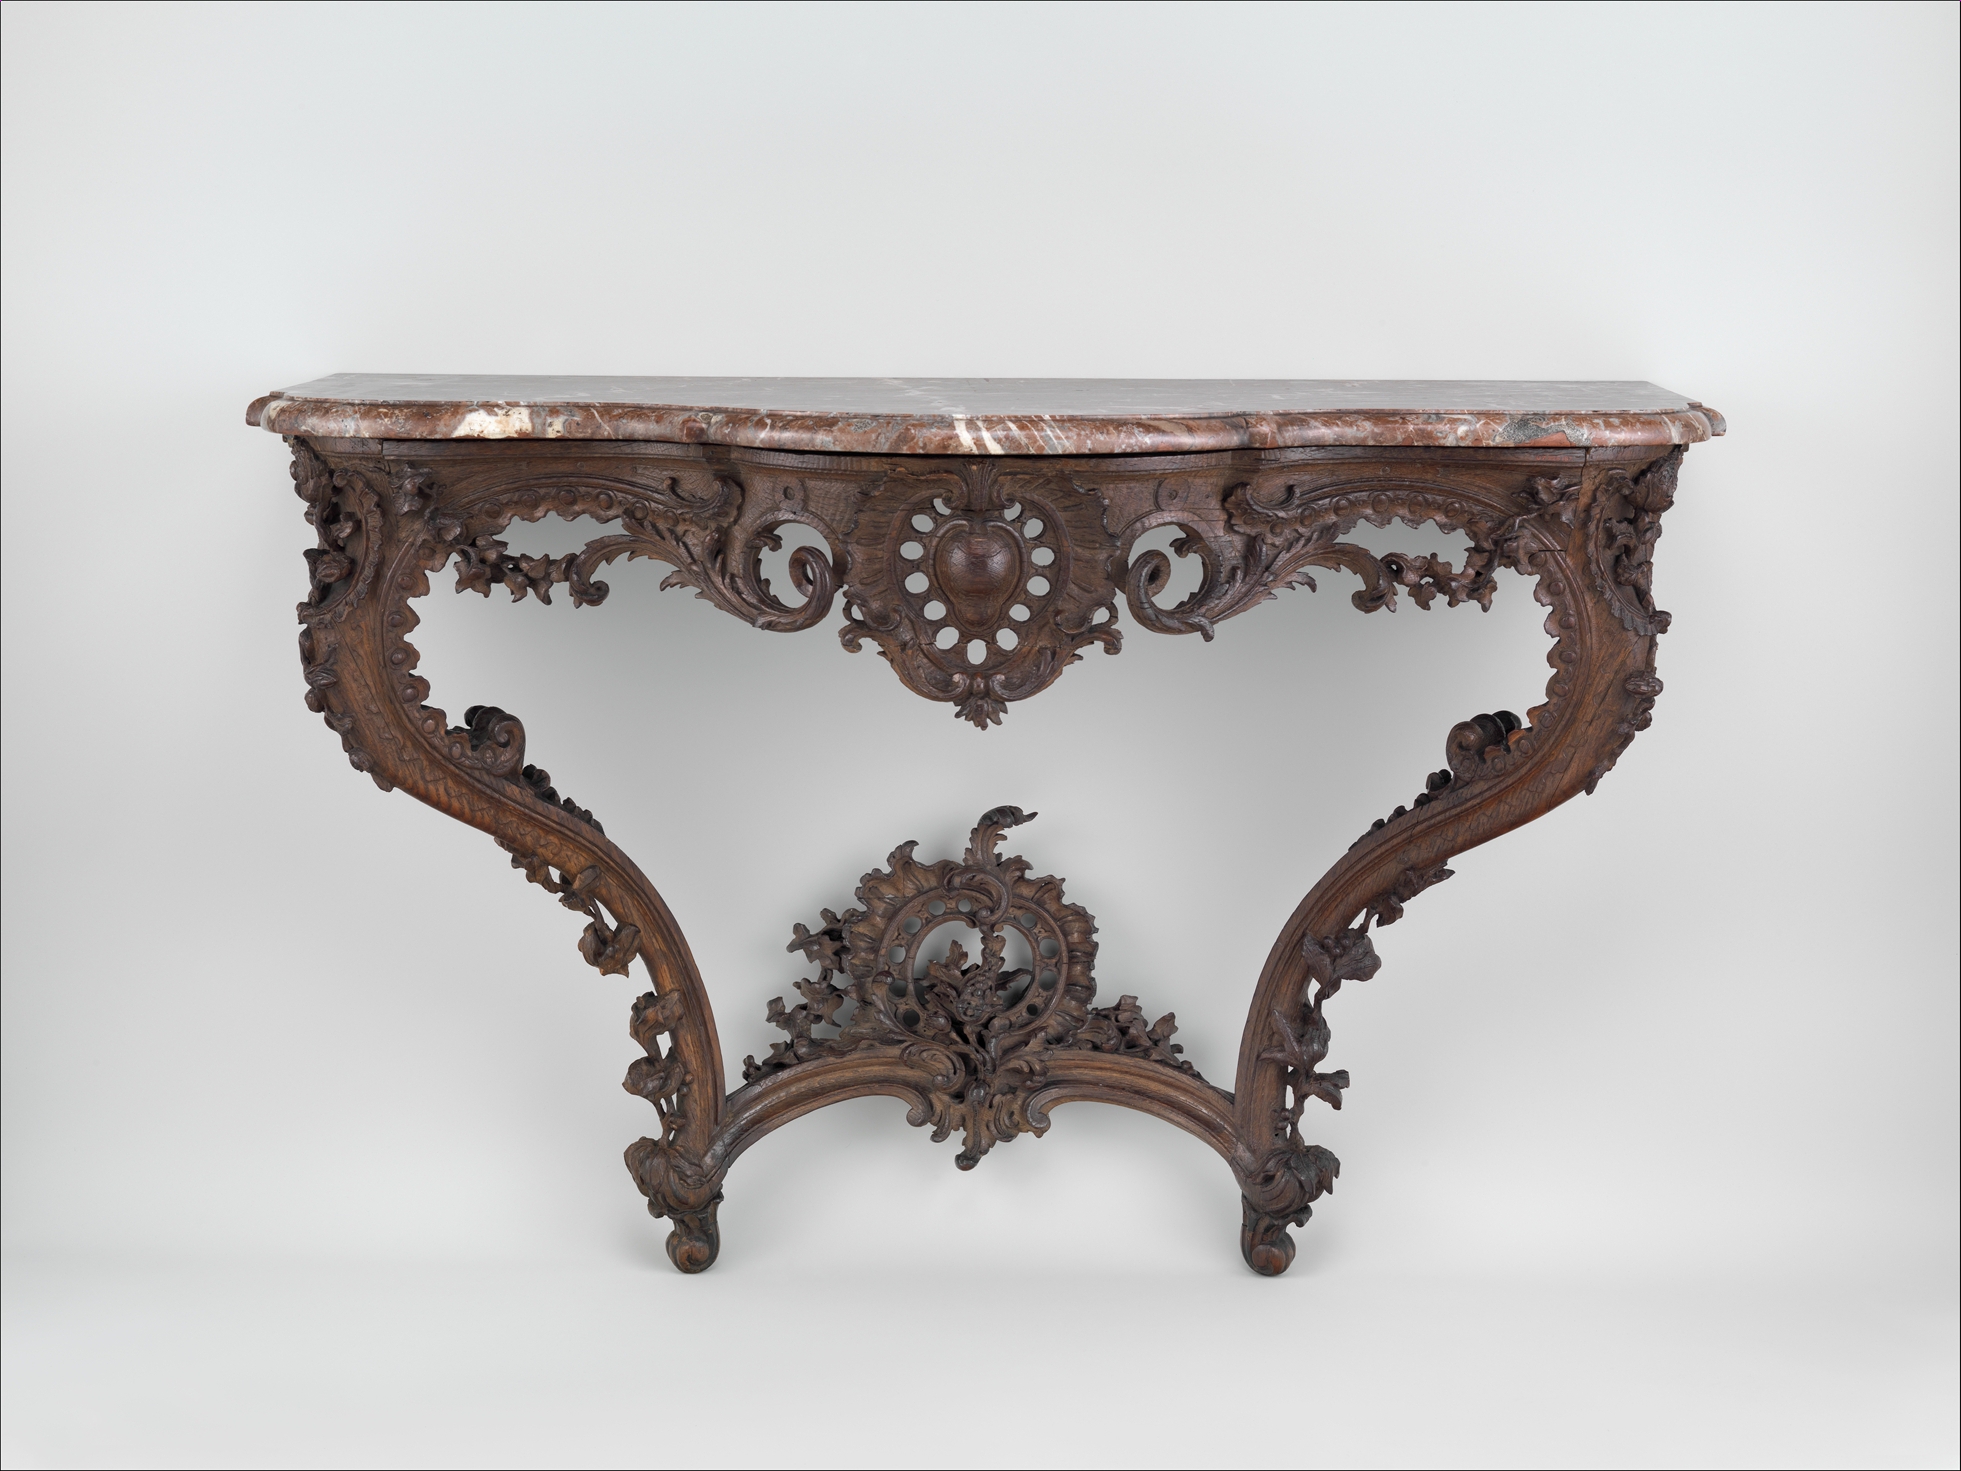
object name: console table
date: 1735-1740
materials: marble, wood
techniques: carving